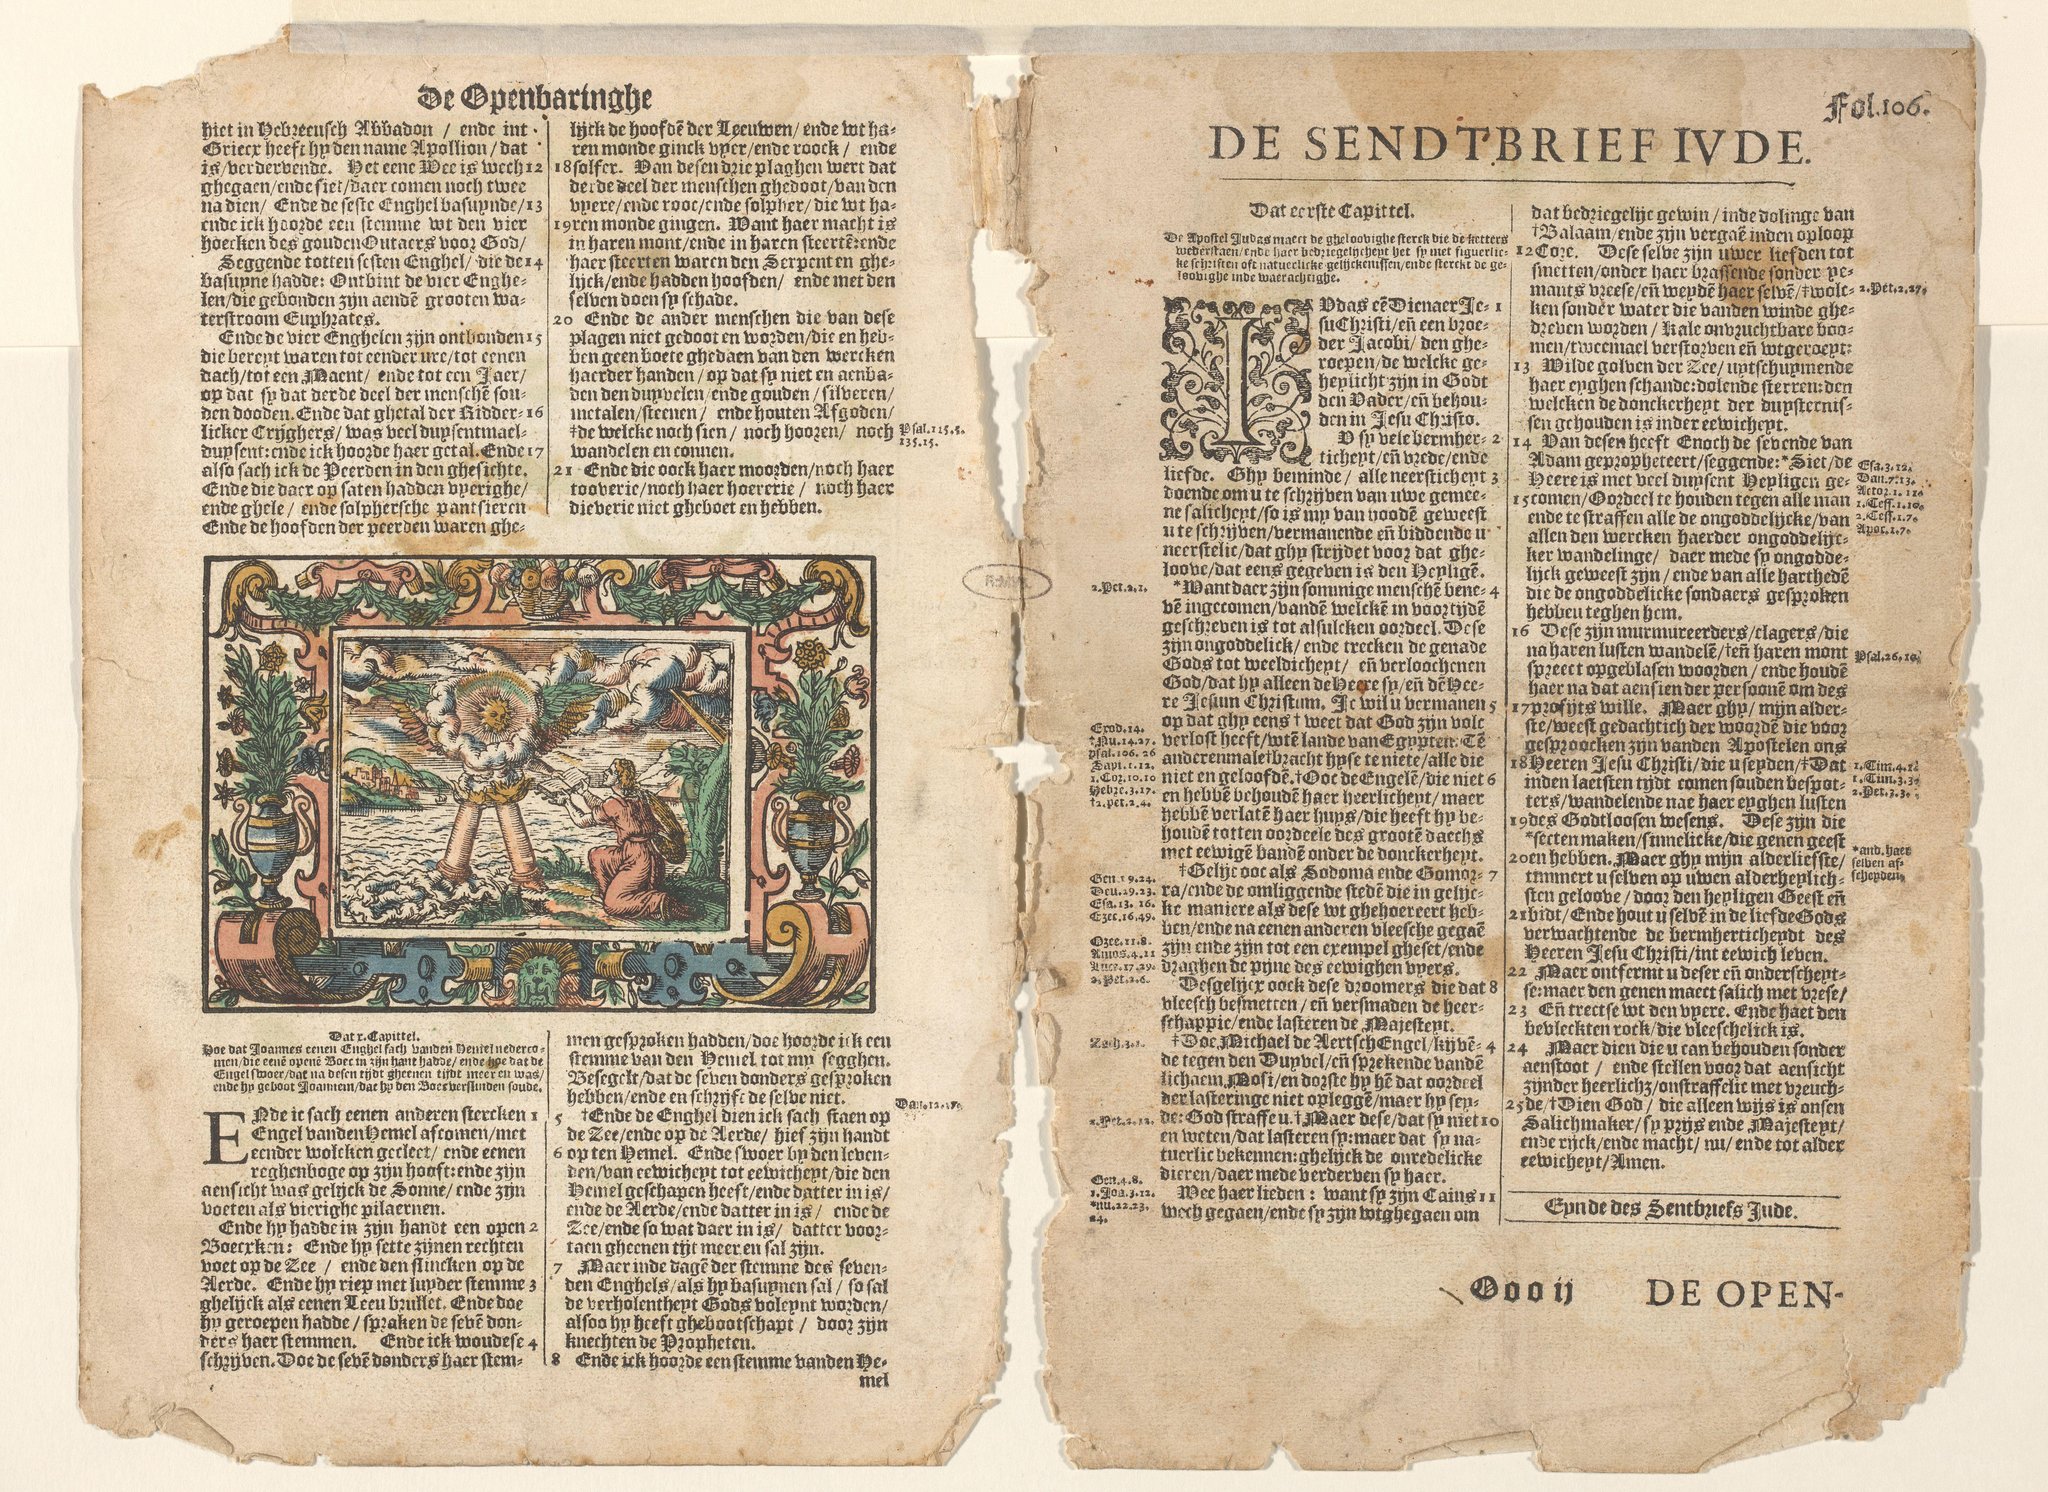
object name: book illustration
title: Voorstelling uit de Openbaring van Johannes (Apocalyps)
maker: Anonymous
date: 1600-1699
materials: paper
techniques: hand coloring, letterpress printing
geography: netherlands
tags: the revelation of john, the apocalypse, the mighty angel with the little open book in his hands: he is wrapped in a cloud; his legs are pillars of fire, which stand one on land and one in the sea ~ apocalypse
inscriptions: collector's mark: Lugt 2228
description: De engel met een gezicht als de zon en benen als zuilen van vuur.